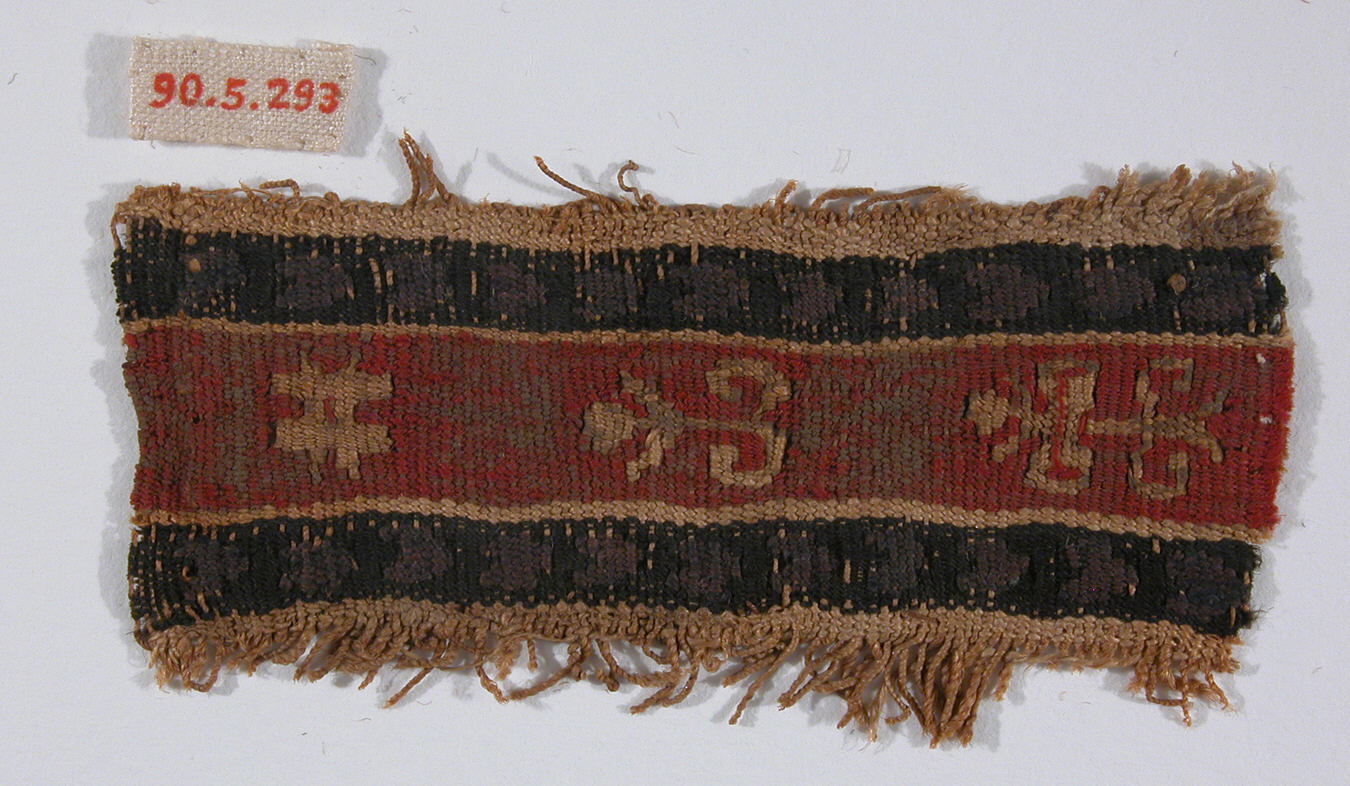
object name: textile fragment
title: Fragment of a Band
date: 401-600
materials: linen, wool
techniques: weave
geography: egypt